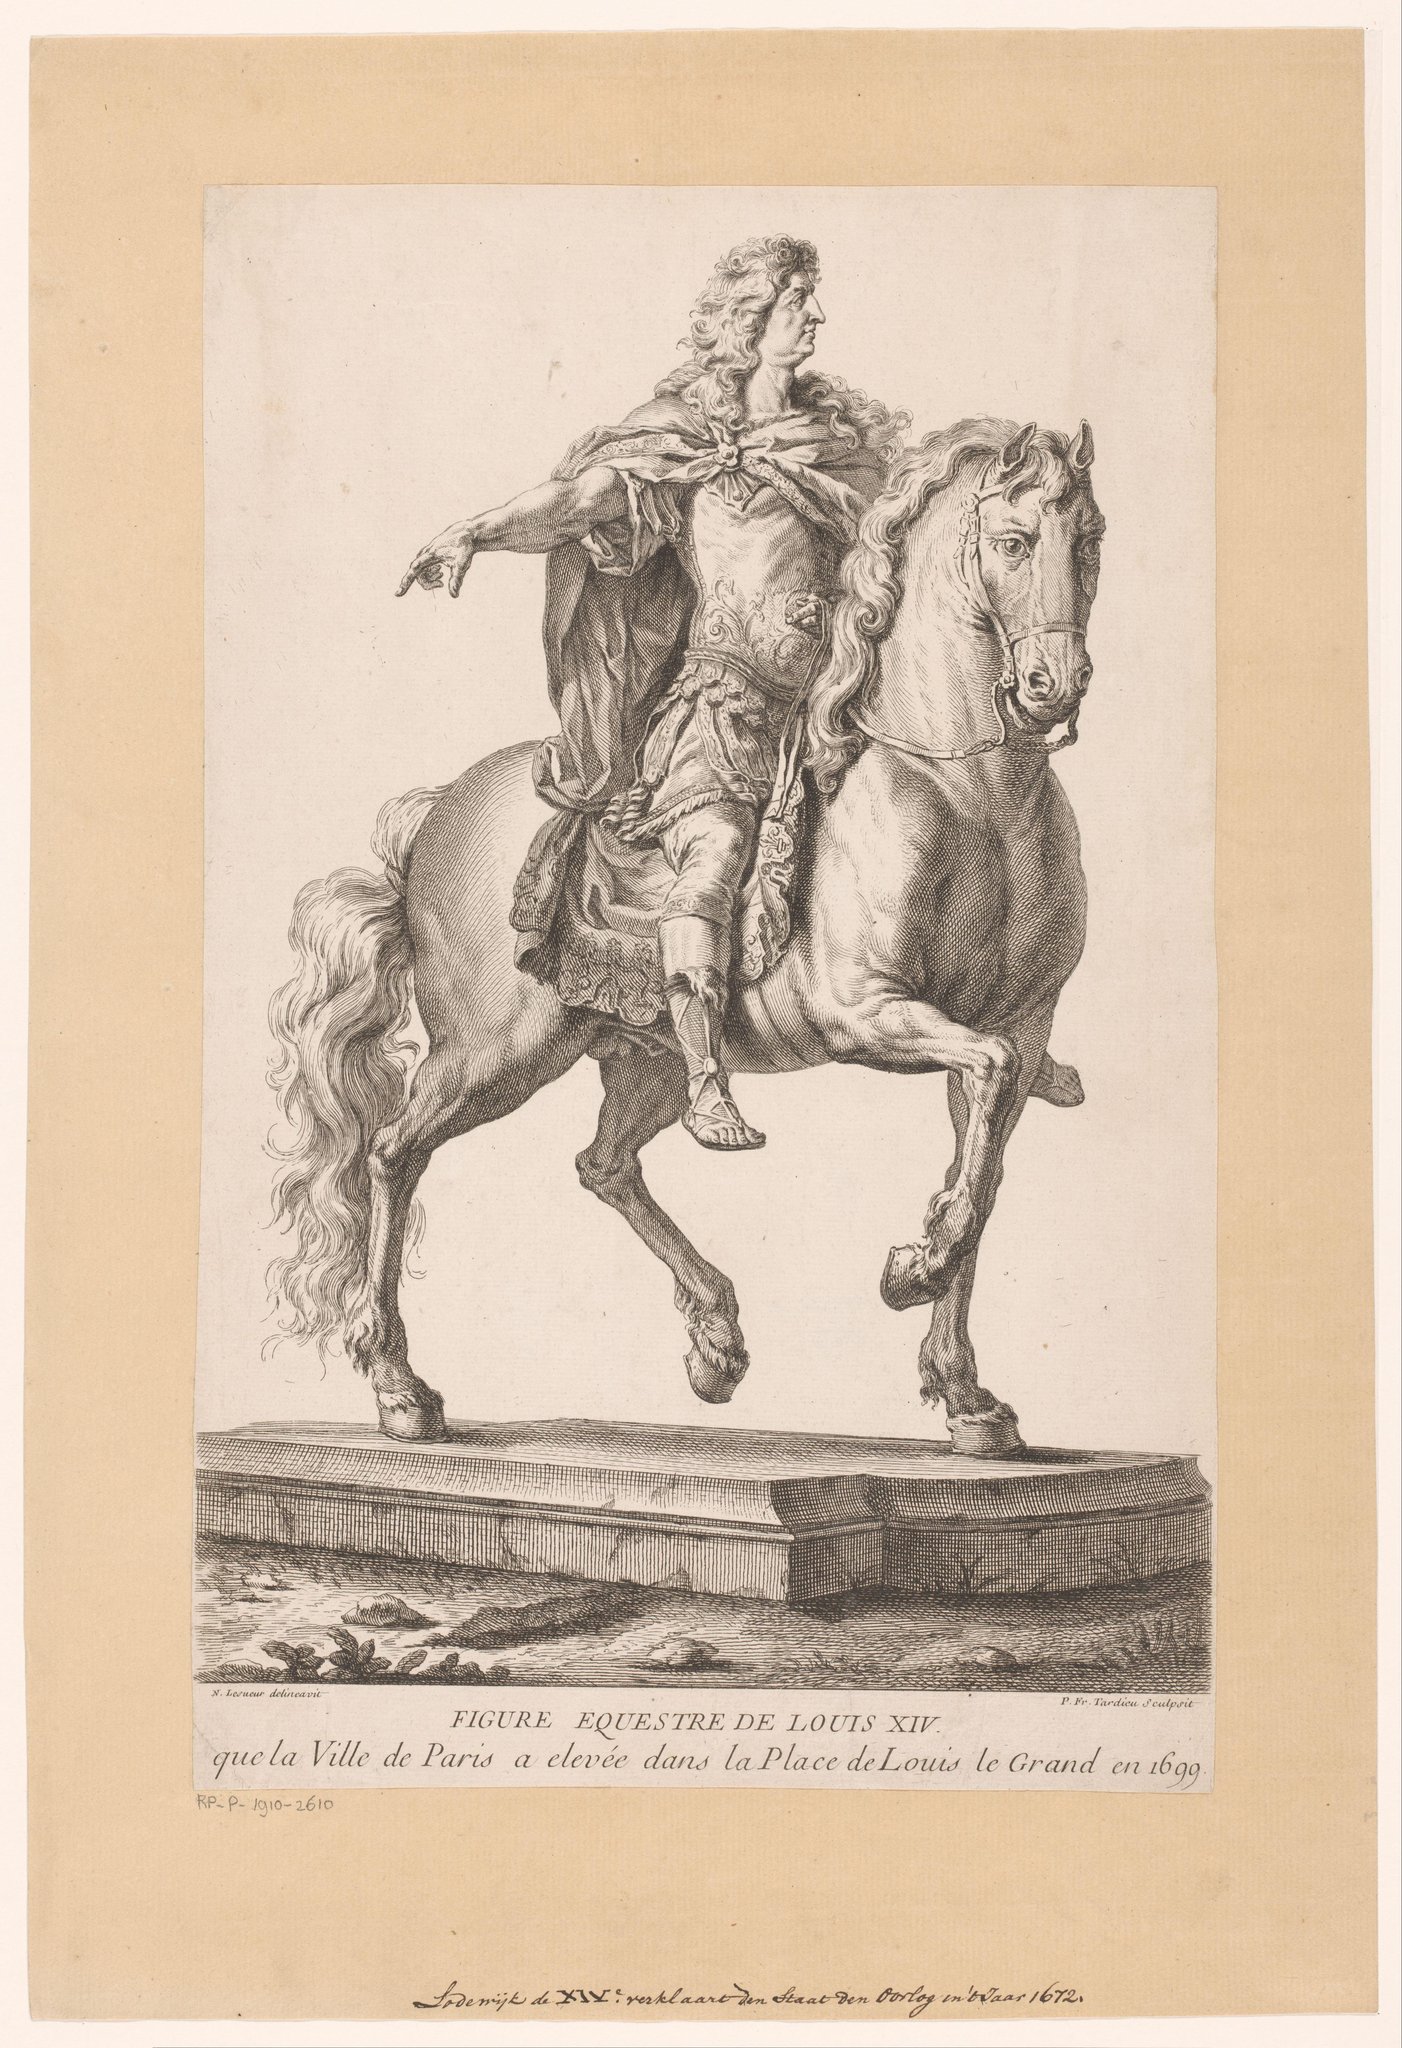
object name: print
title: Figure Equestre de Louis XIV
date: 1721-1771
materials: paper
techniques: engraving, etching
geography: paris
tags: lodewijk xiv (koning van frankrijk), historical persons, equestrian statue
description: Naar standbeeld van Lodewijk XIV, kijkend naar rechts.